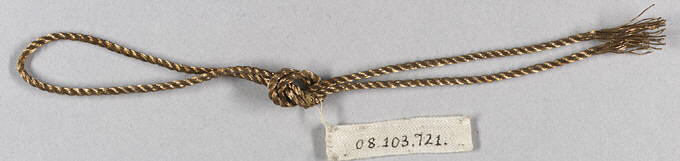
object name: thread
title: Tinsel and metal thread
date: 1601-1800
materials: metal thread